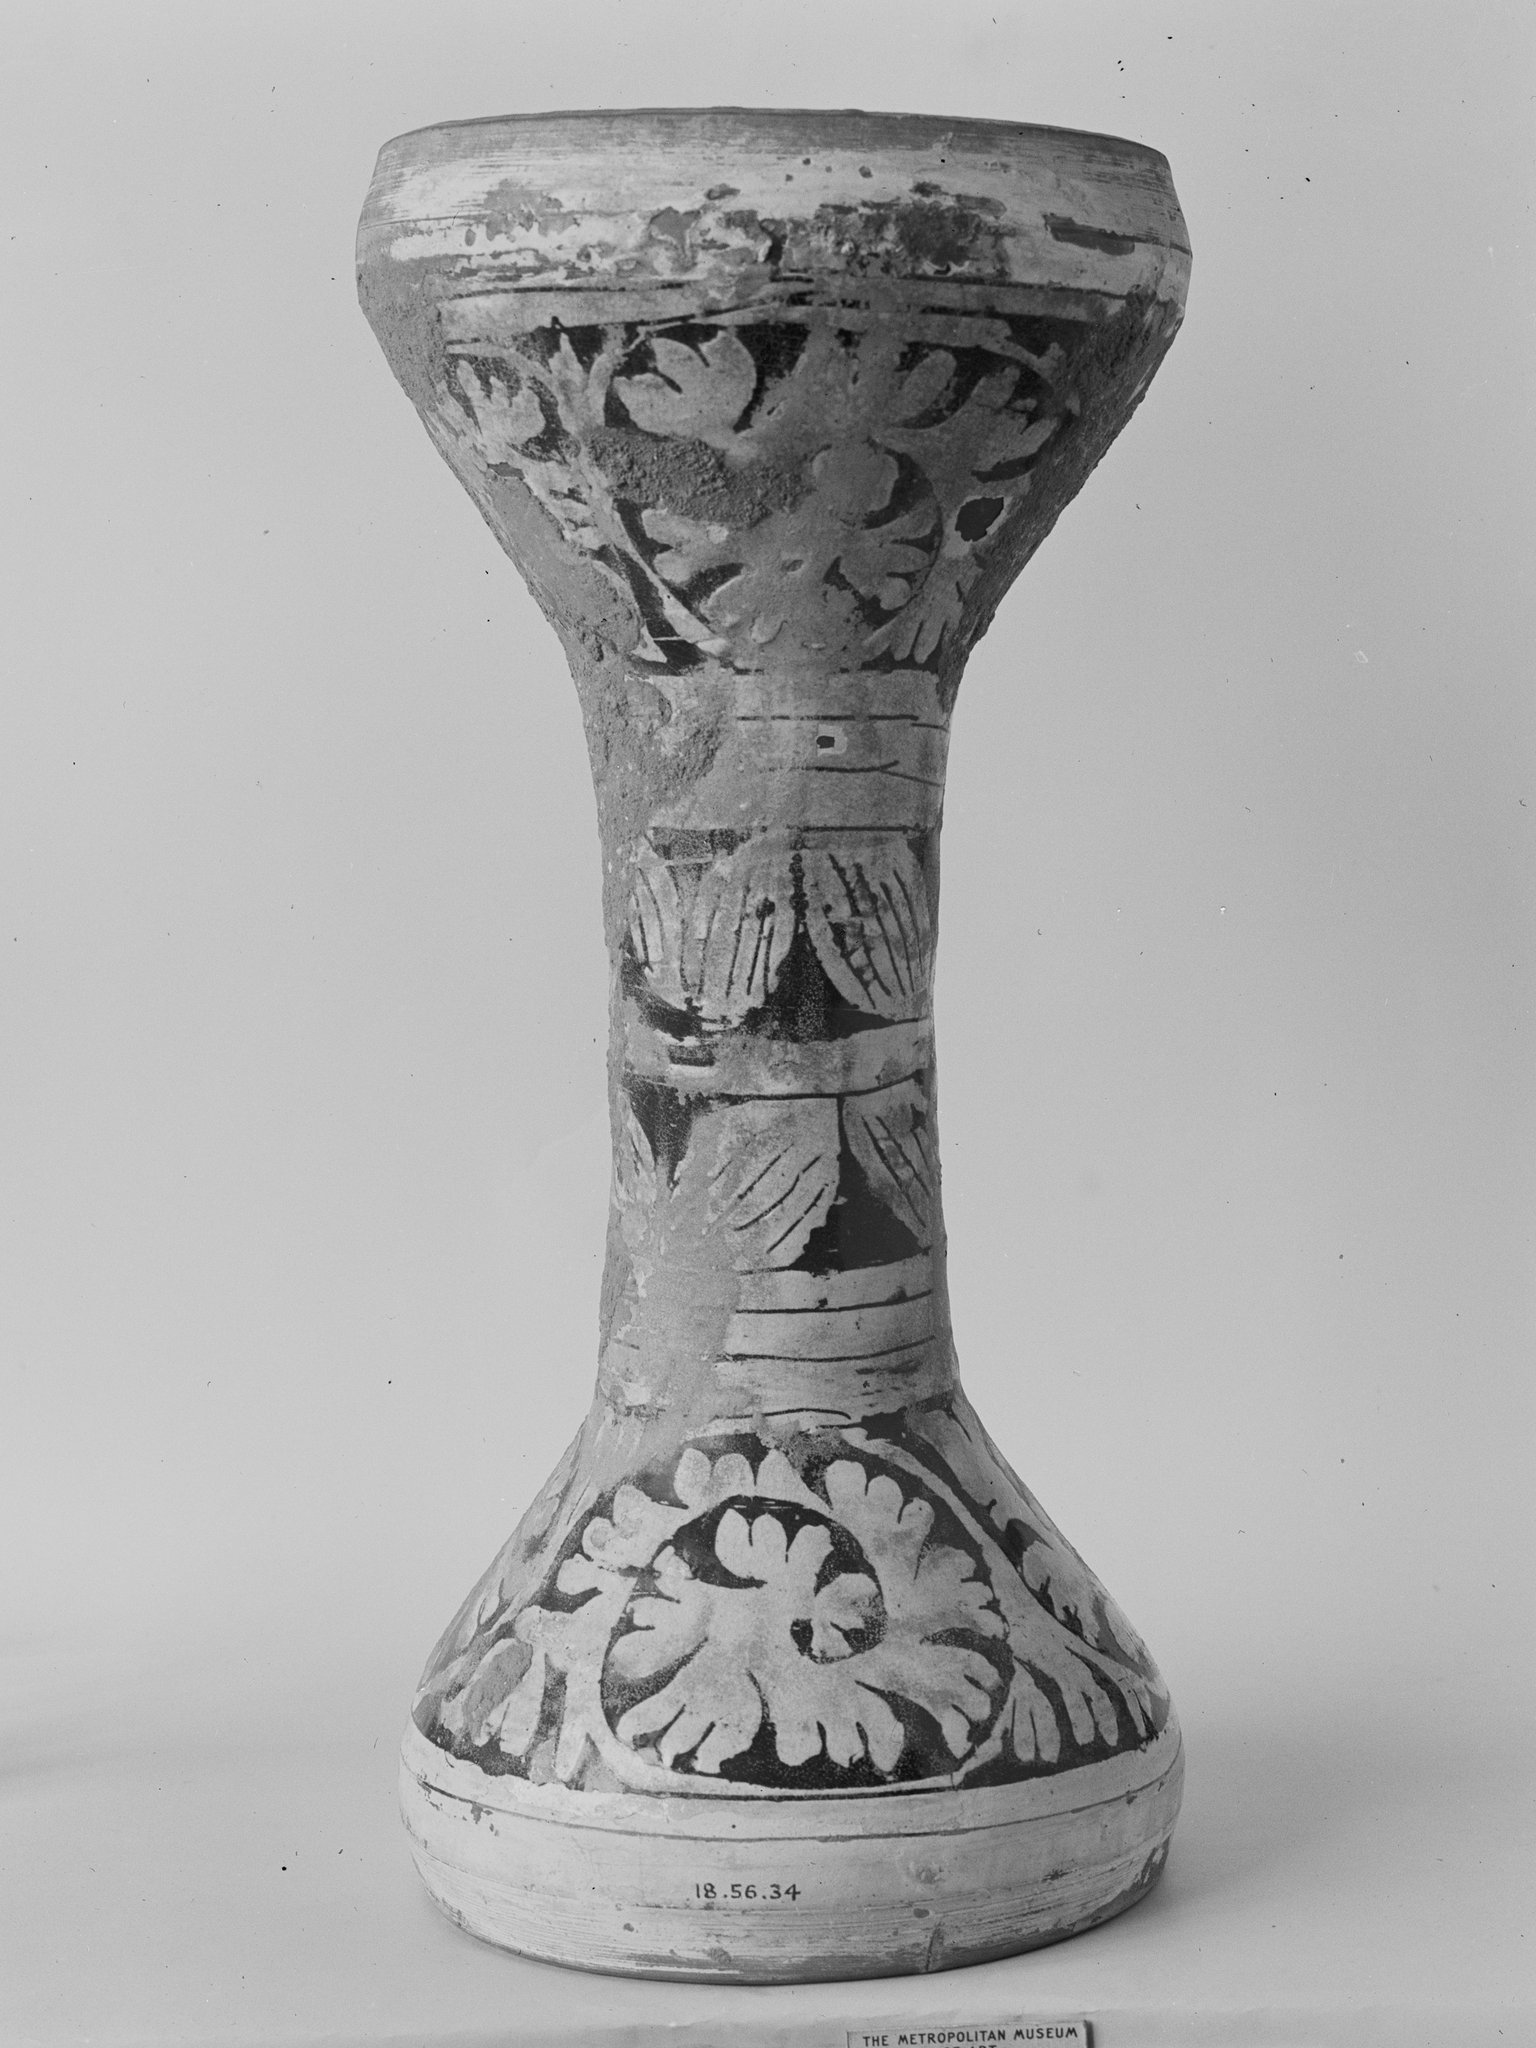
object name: drum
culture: chinese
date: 618-907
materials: pottery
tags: drums